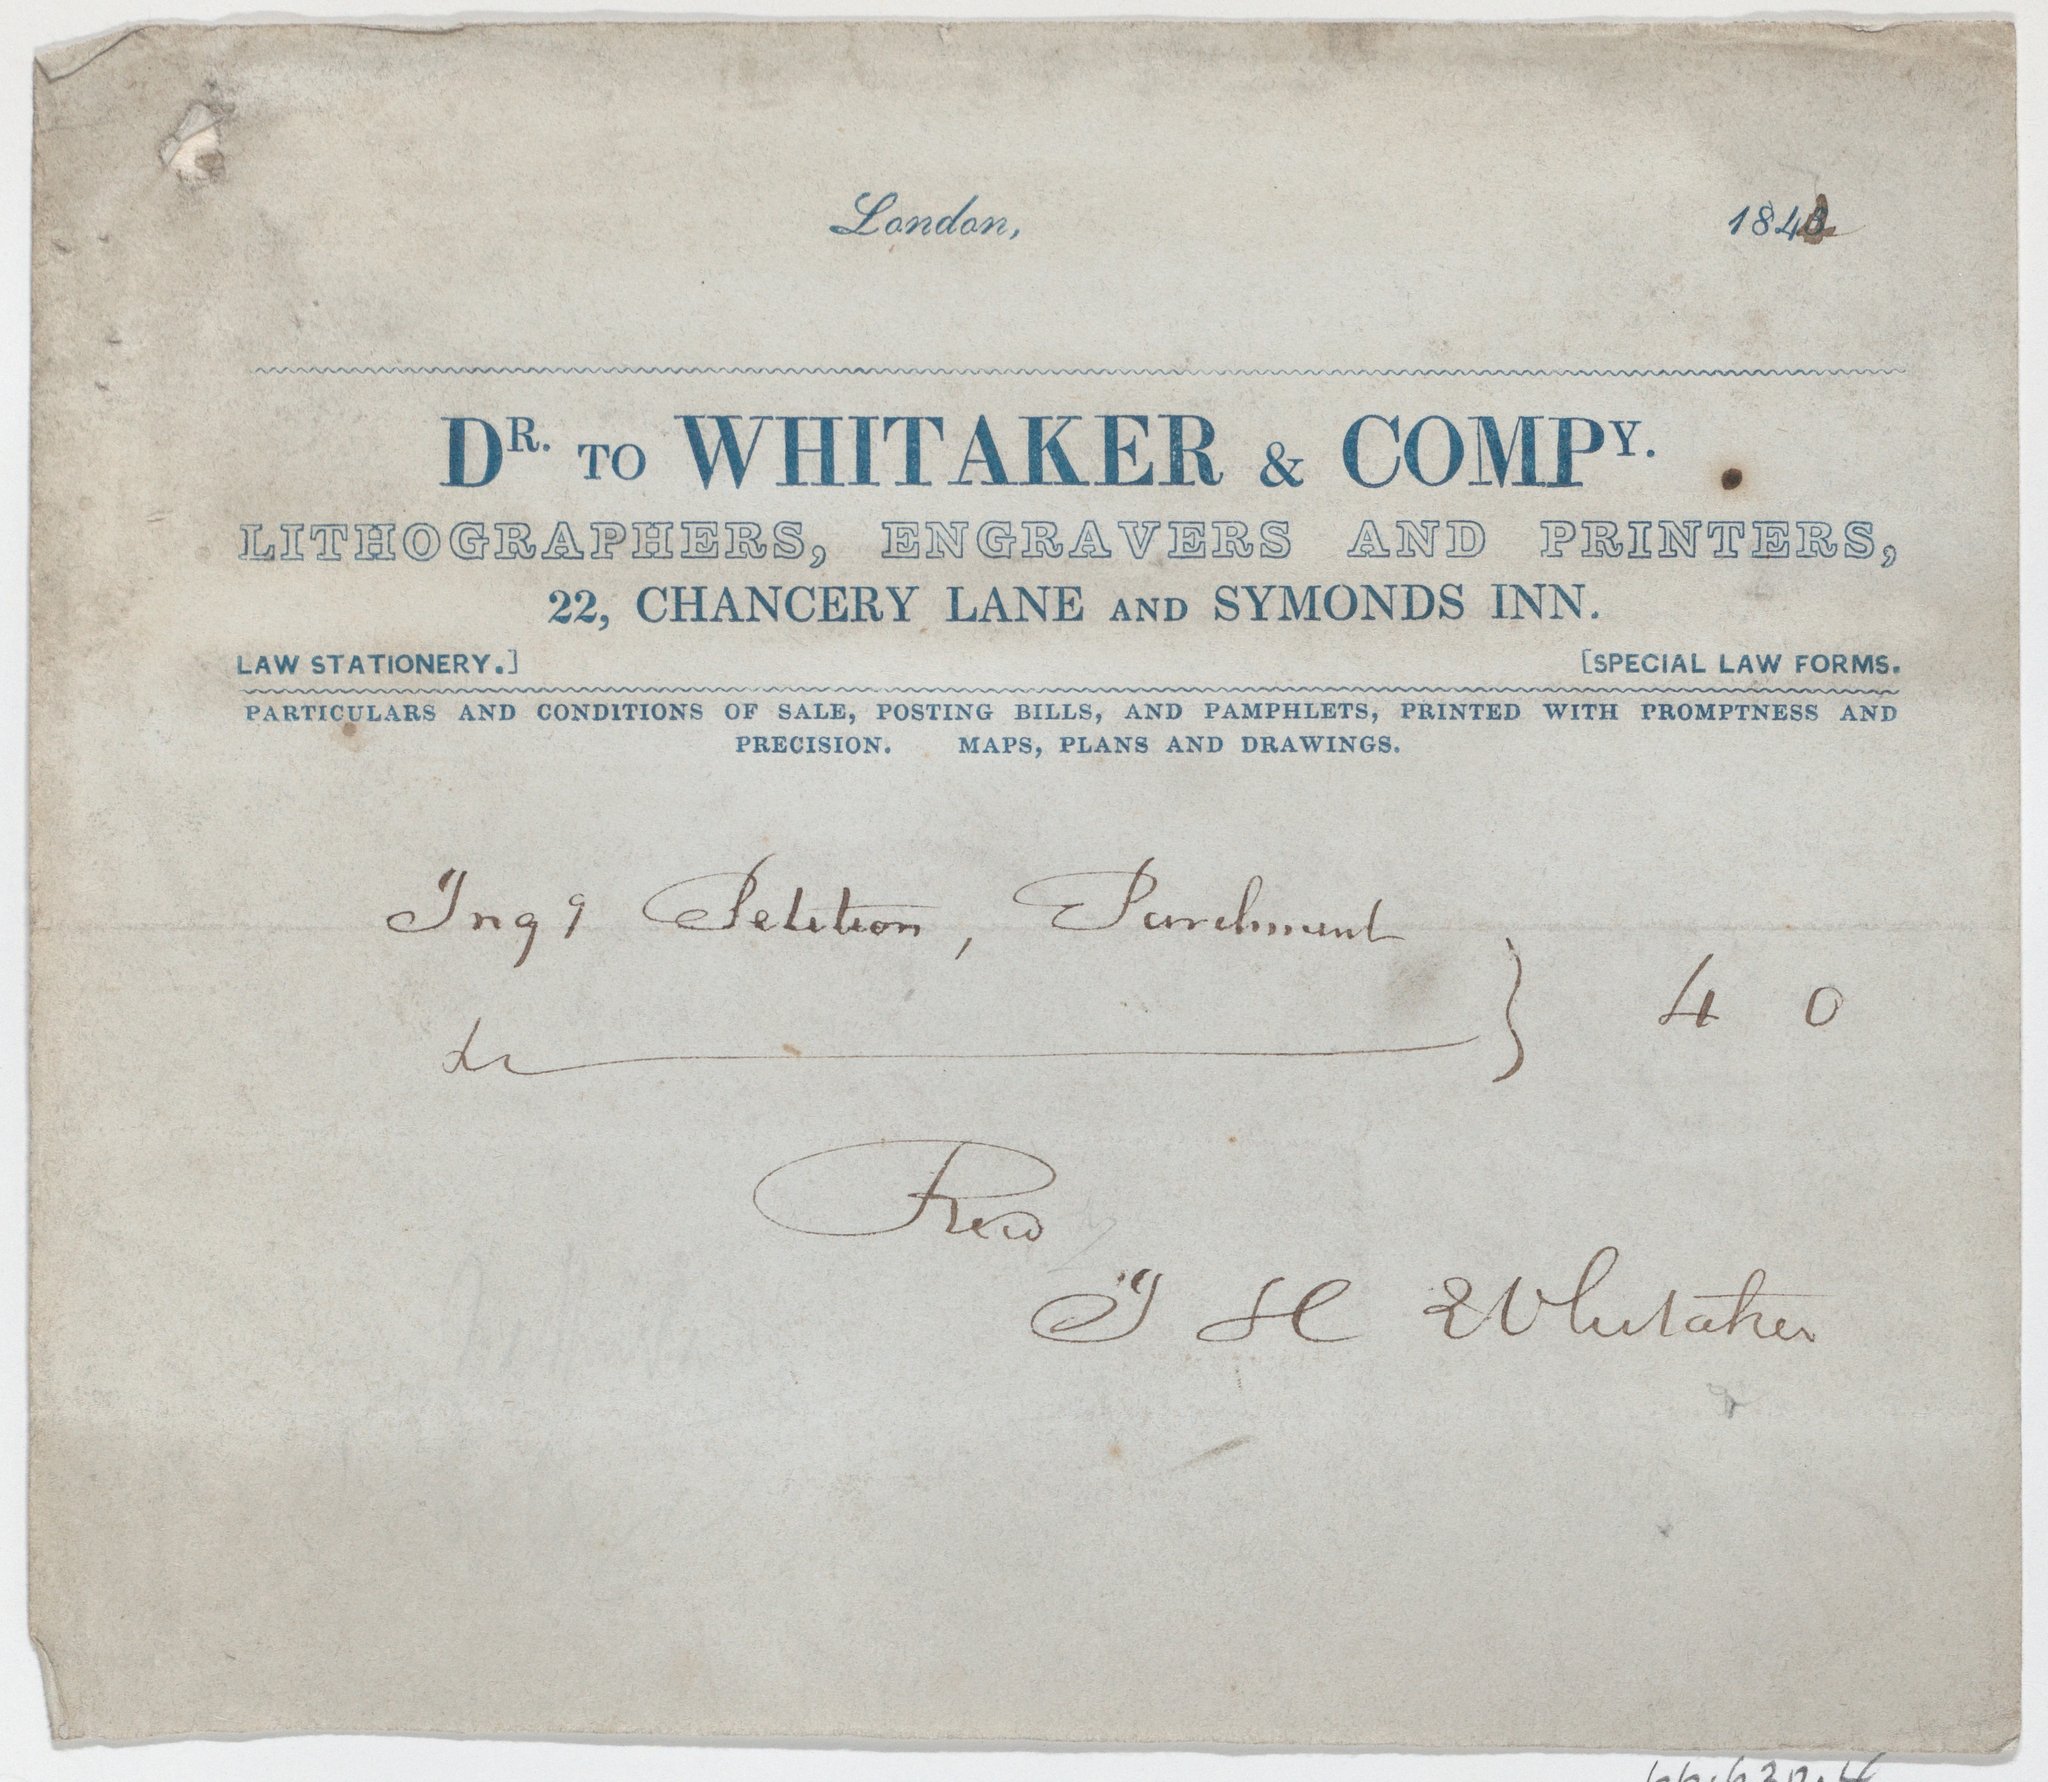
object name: print, trade card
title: Trade Card for Dr. Whitaker & Co., Lithogravers, Engravers and Printers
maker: anonymous, british, 19th century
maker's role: artist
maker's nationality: british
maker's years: 1800-1900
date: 1801-1900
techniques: lithography